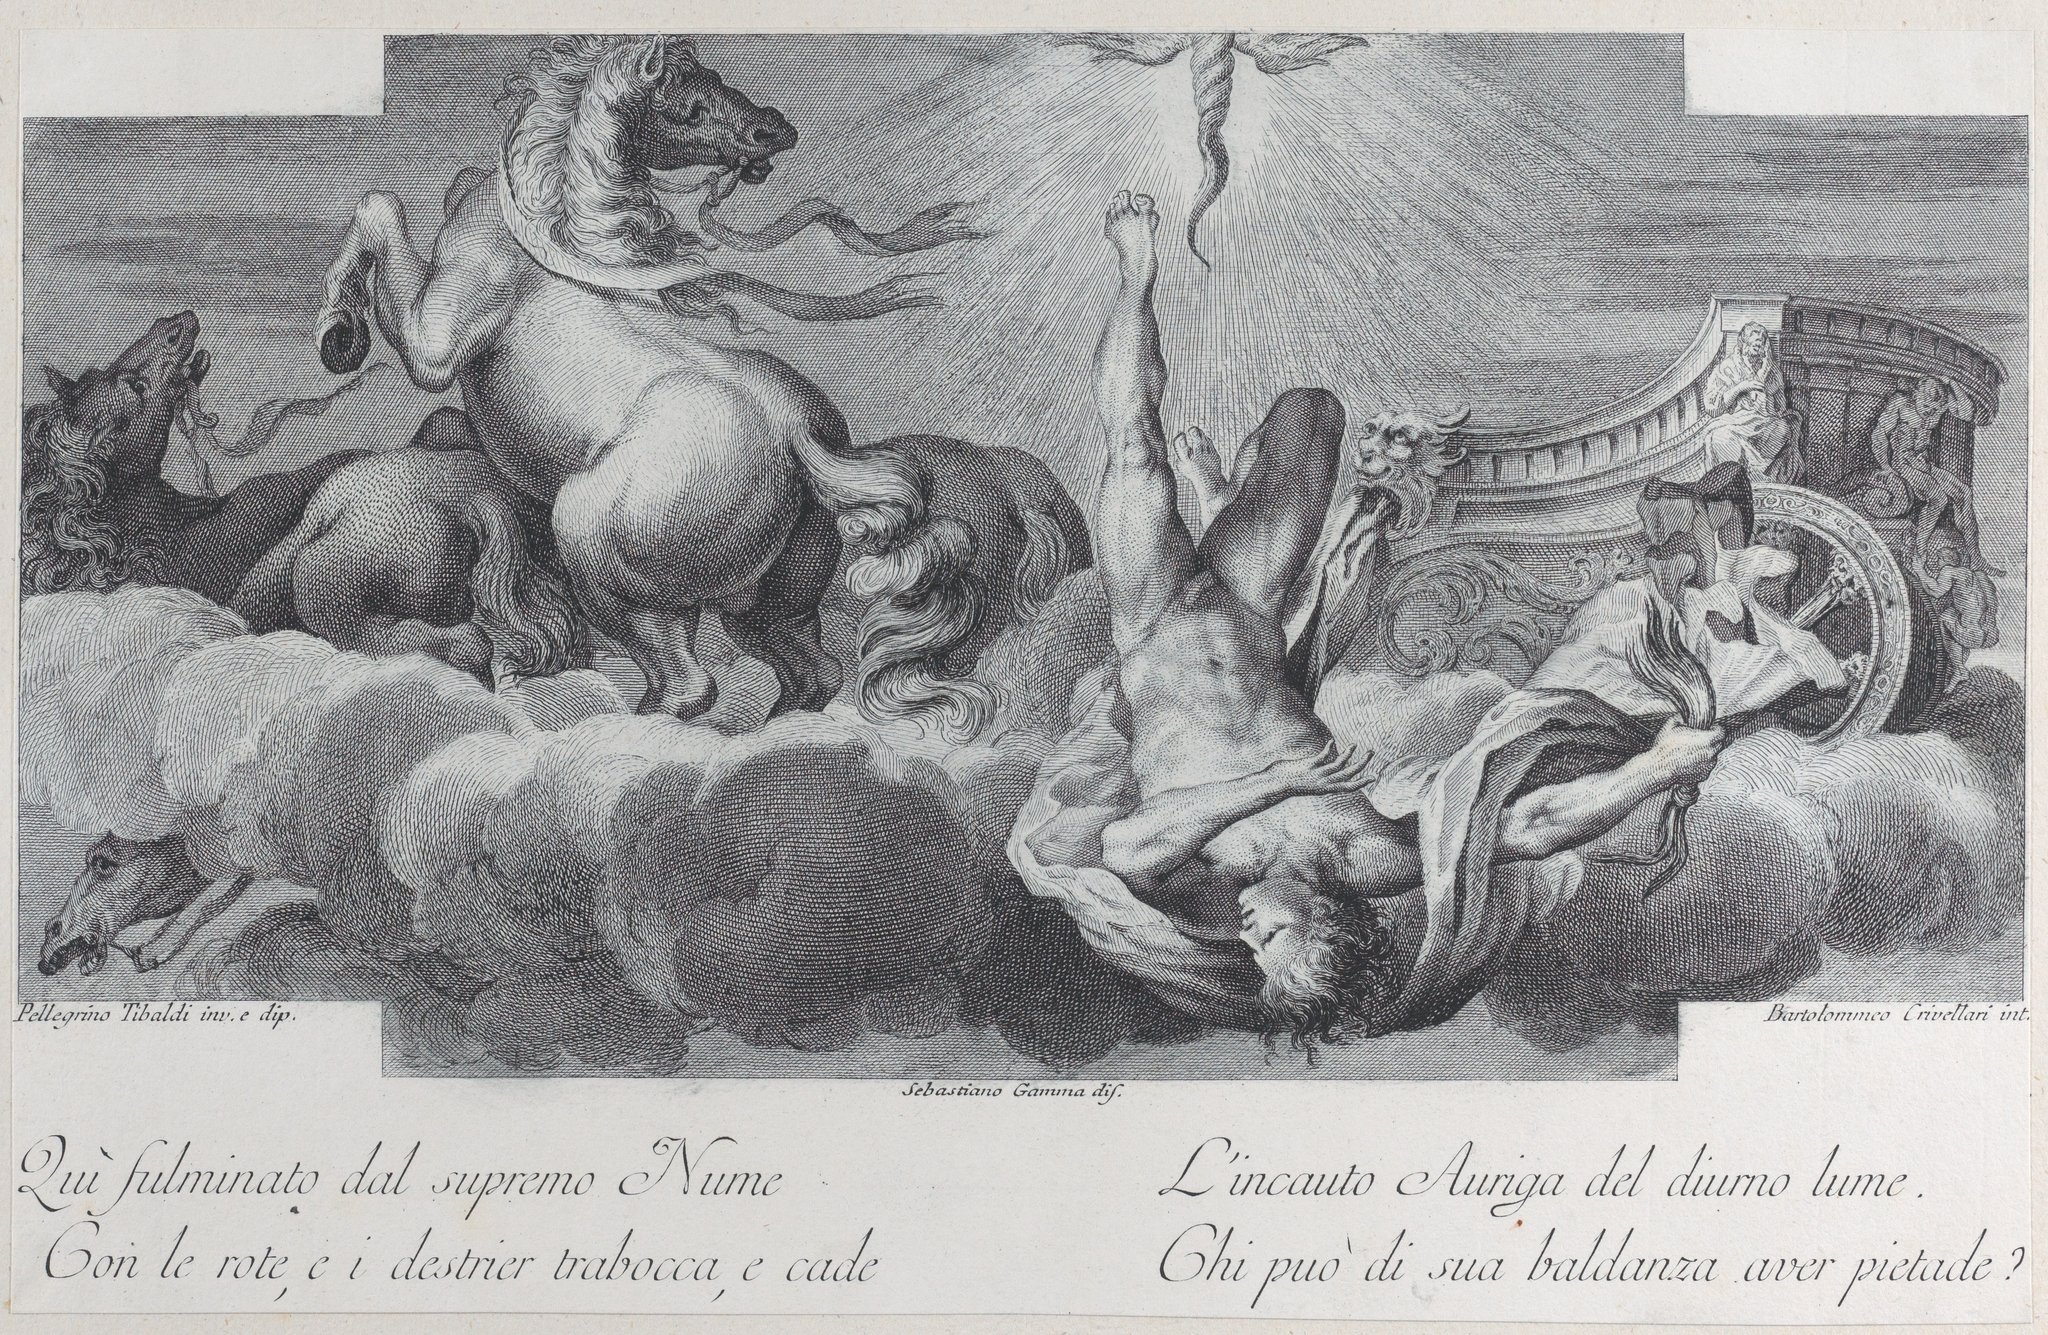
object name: print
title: Plate 34: Auriga, the charioteer, falls from the chariot at center, with three horses at left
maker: bartolomeo crivellari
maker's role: artist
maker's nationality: italian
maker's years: 1700-1800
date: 1756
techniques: engraving, etching